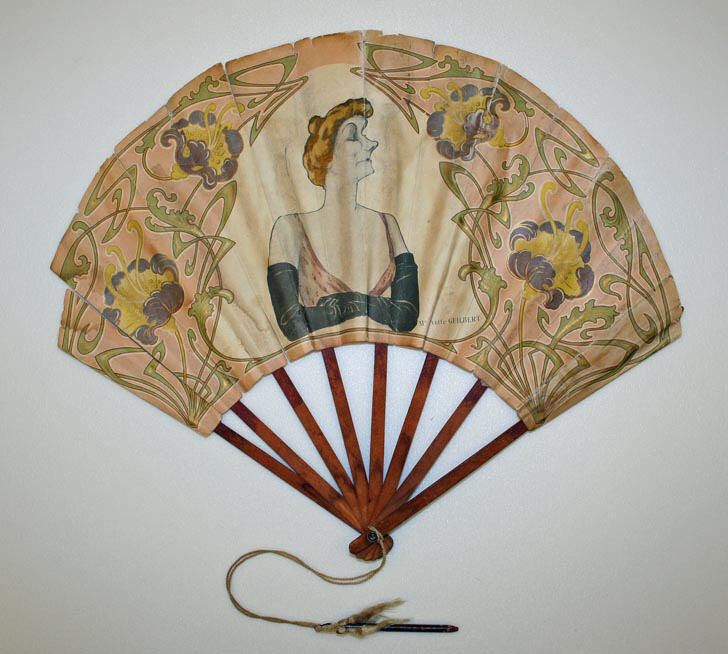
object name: fan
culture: french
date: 1903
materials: paper, silk, wood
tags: profiles,flowers